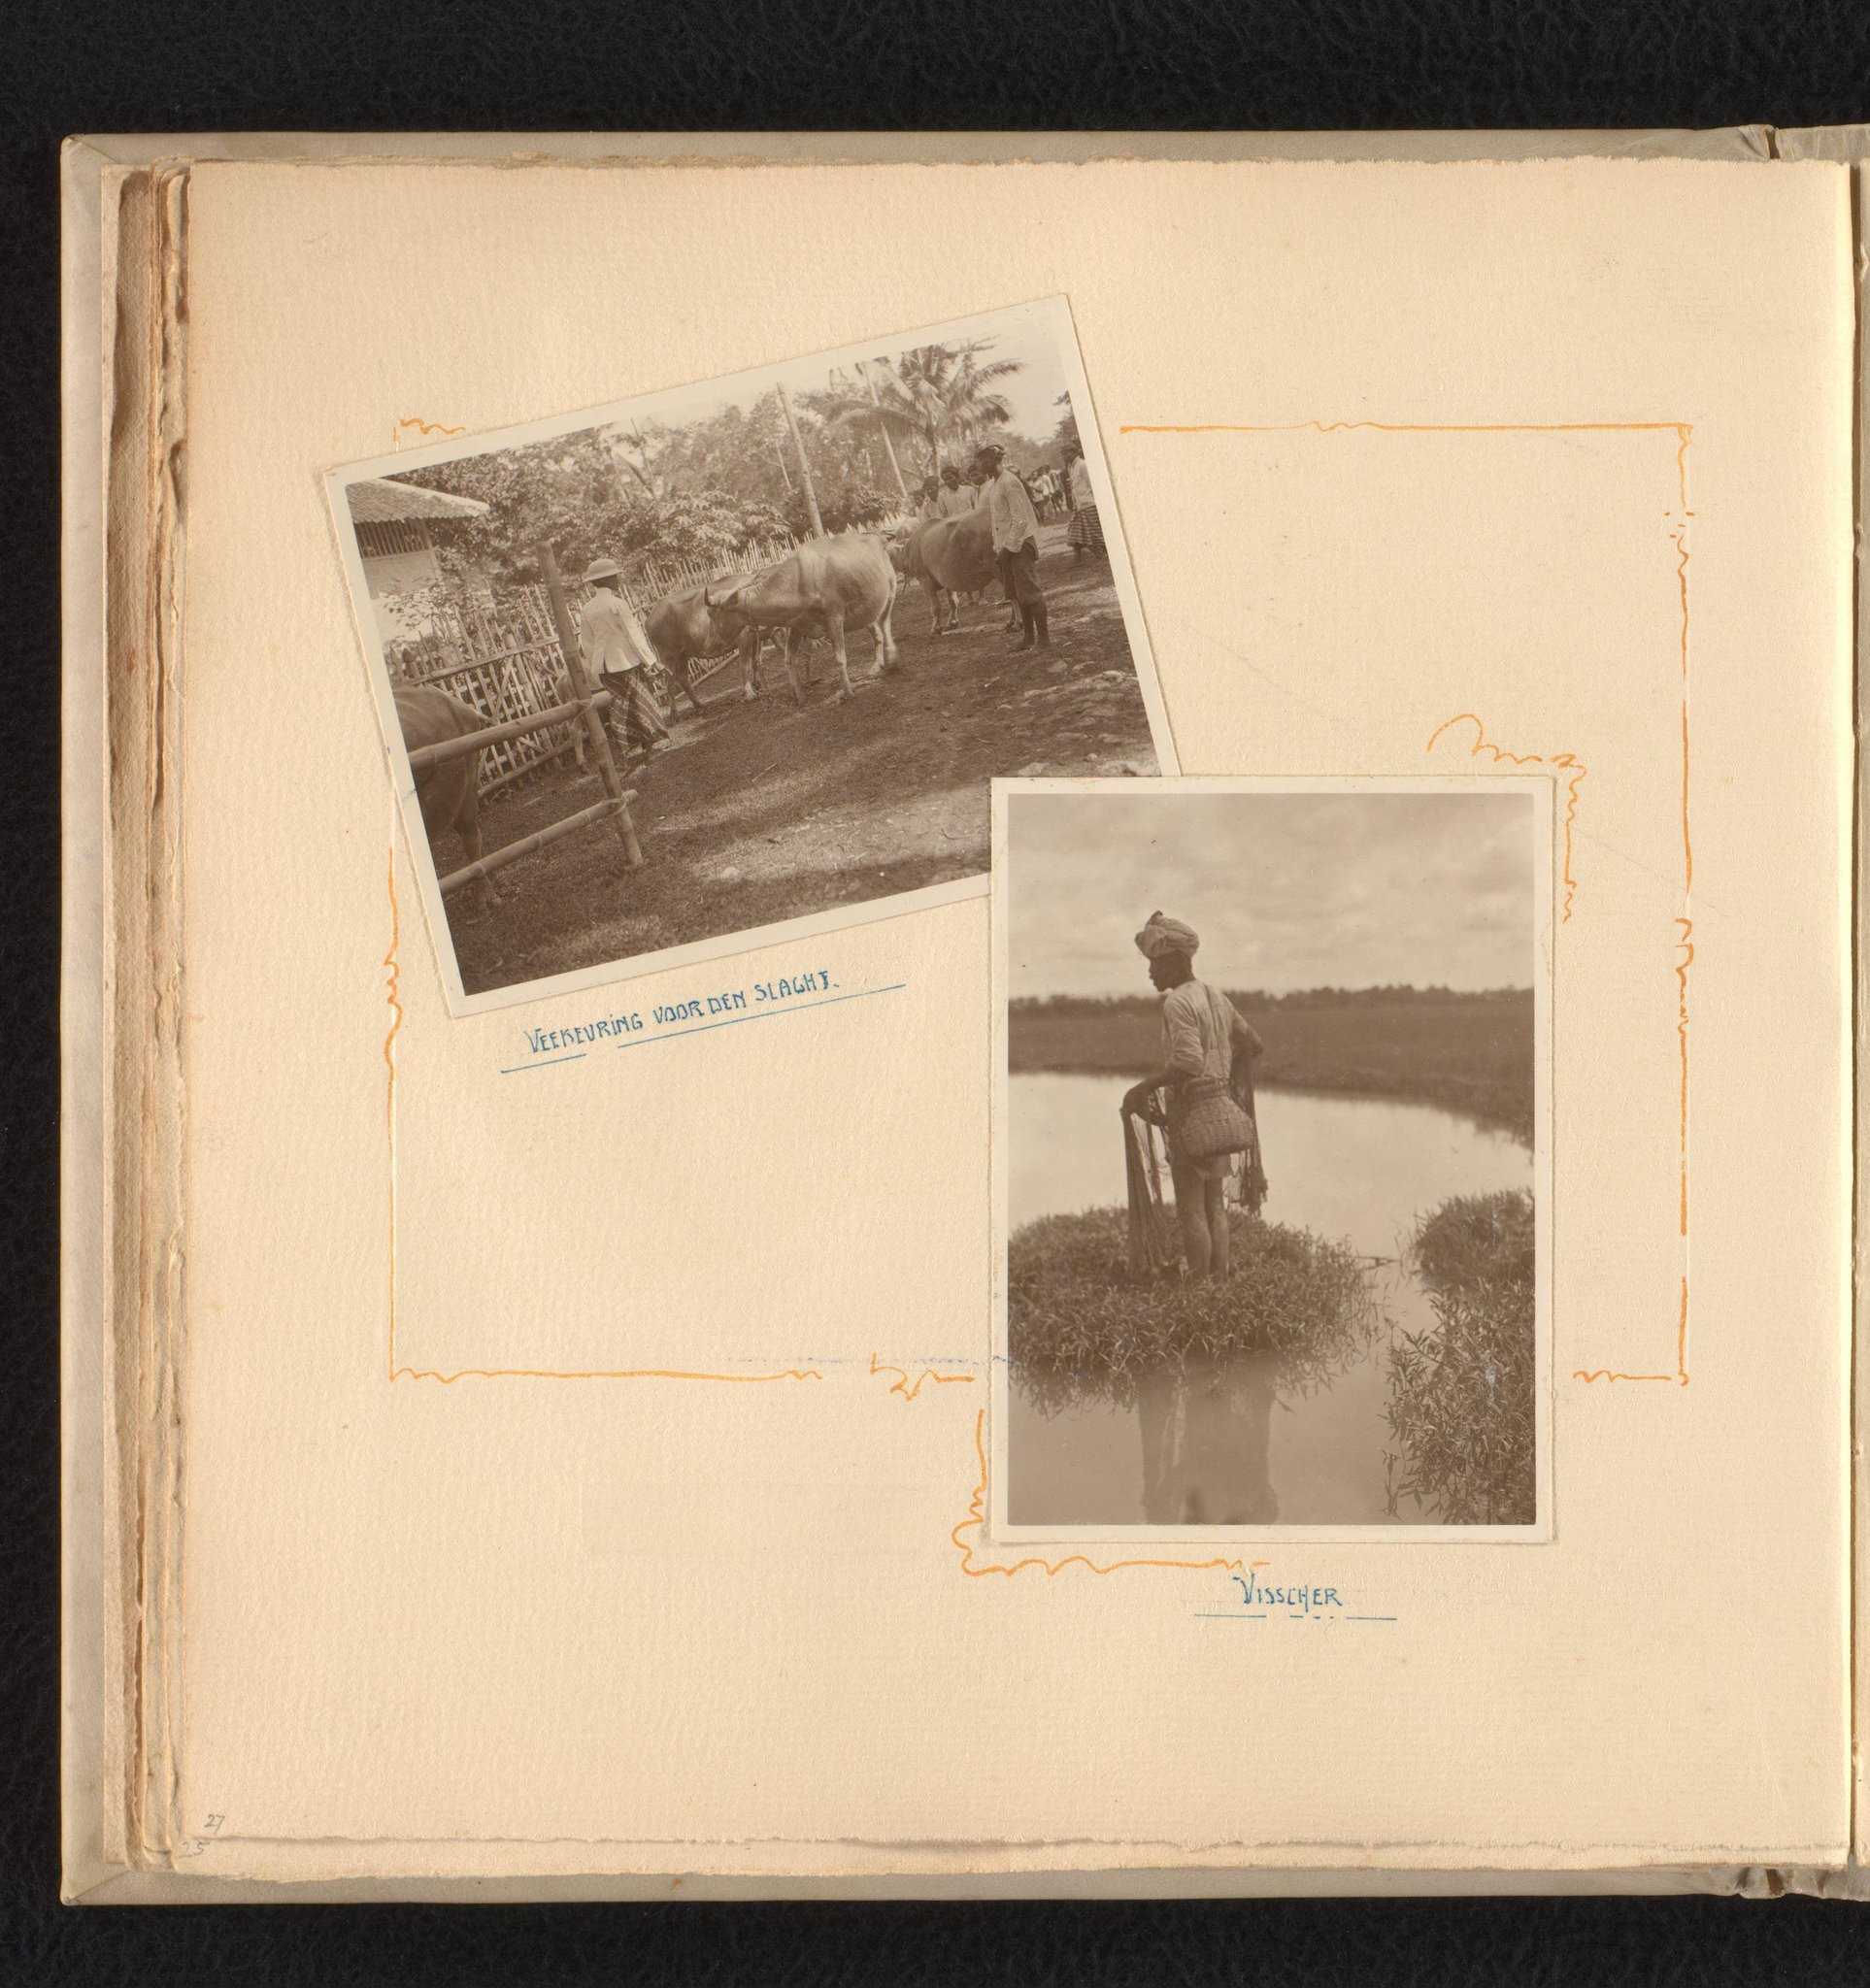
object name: photograph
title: Veeteelt en visserij in Grobogan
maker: Anonymous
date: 1910-1928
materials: paper, photographic support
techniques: drawing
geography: grobogan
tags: commercial fishery, cattle-breeding, livestock industry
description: Albumblad met twee foto's over veeteelt en visserij in Grobogan. Het blad is versierd met randwerk om de foto's. Onderdeel van het fotoalbum aangeboden aan J. Habbema door het Binnenlandsch Bestuur Corps van het Regentschap Grobogan, bij het beëindigen van zijn bestuur over het Regentschap, waarschijnlijk in 1928.